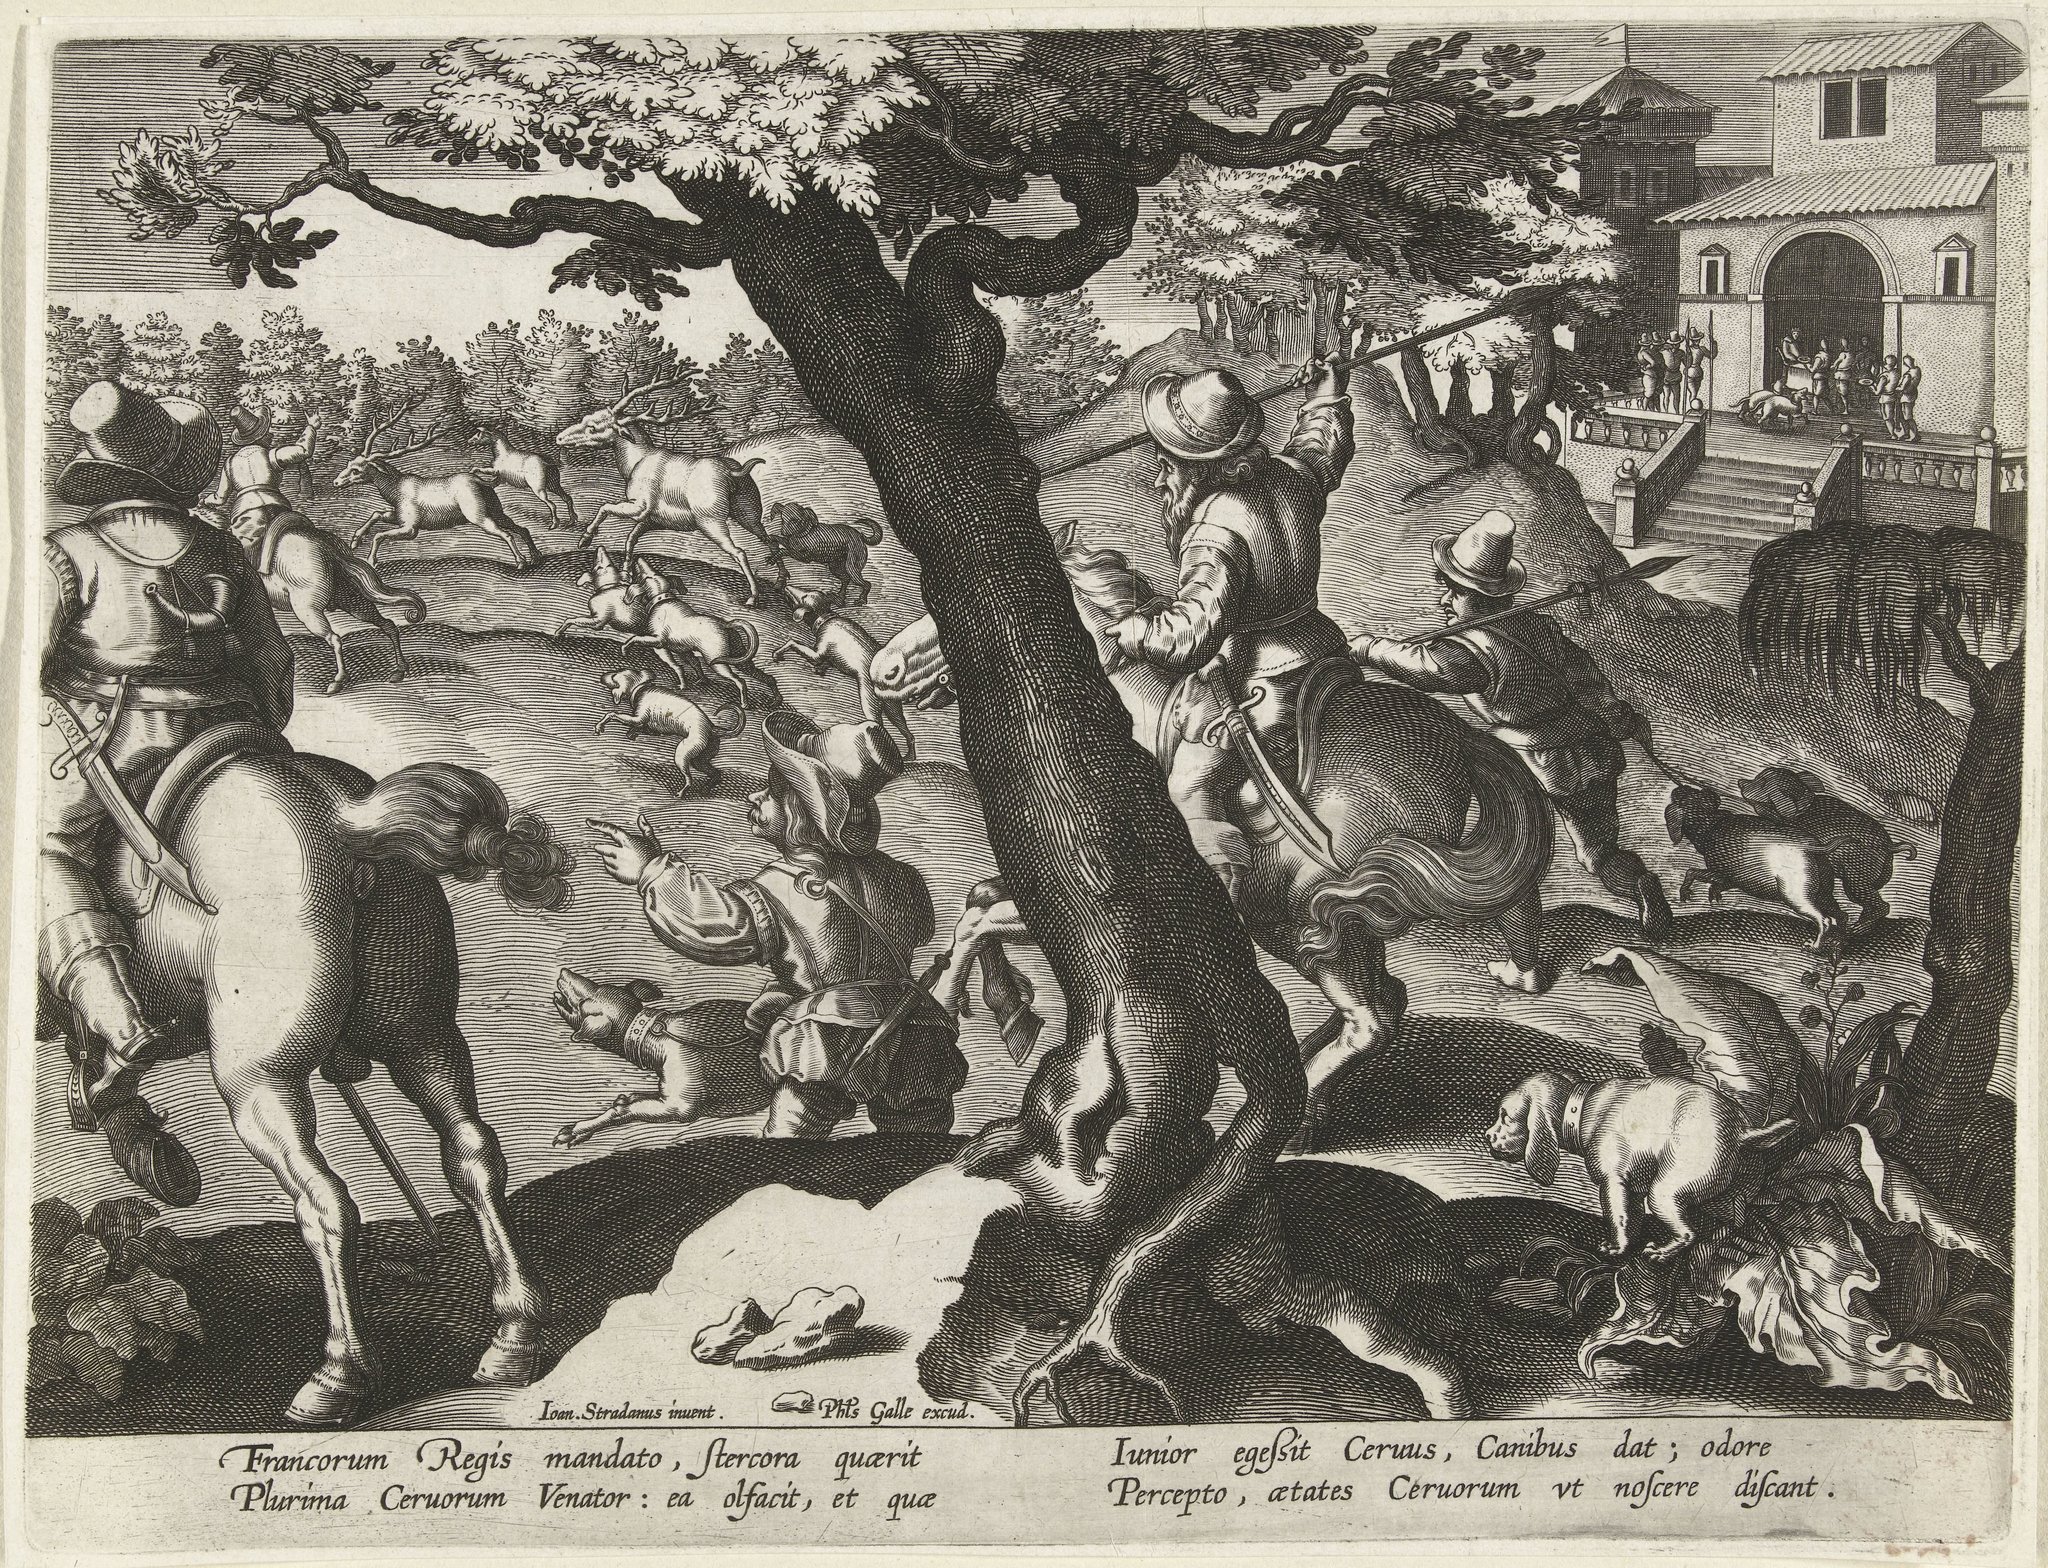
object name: print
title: Jachttaferelen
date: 1594-1598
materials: paper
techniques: engraving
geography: florence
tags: stag-hunting, hunting dogs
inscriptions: collector's mark: Lugt 240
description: Op de voorgrond worden drie herten nagezeten door honden en jagers te paard. De prent heeft een Latijns onderschrift en is deel van een serie over jachttaferelen.